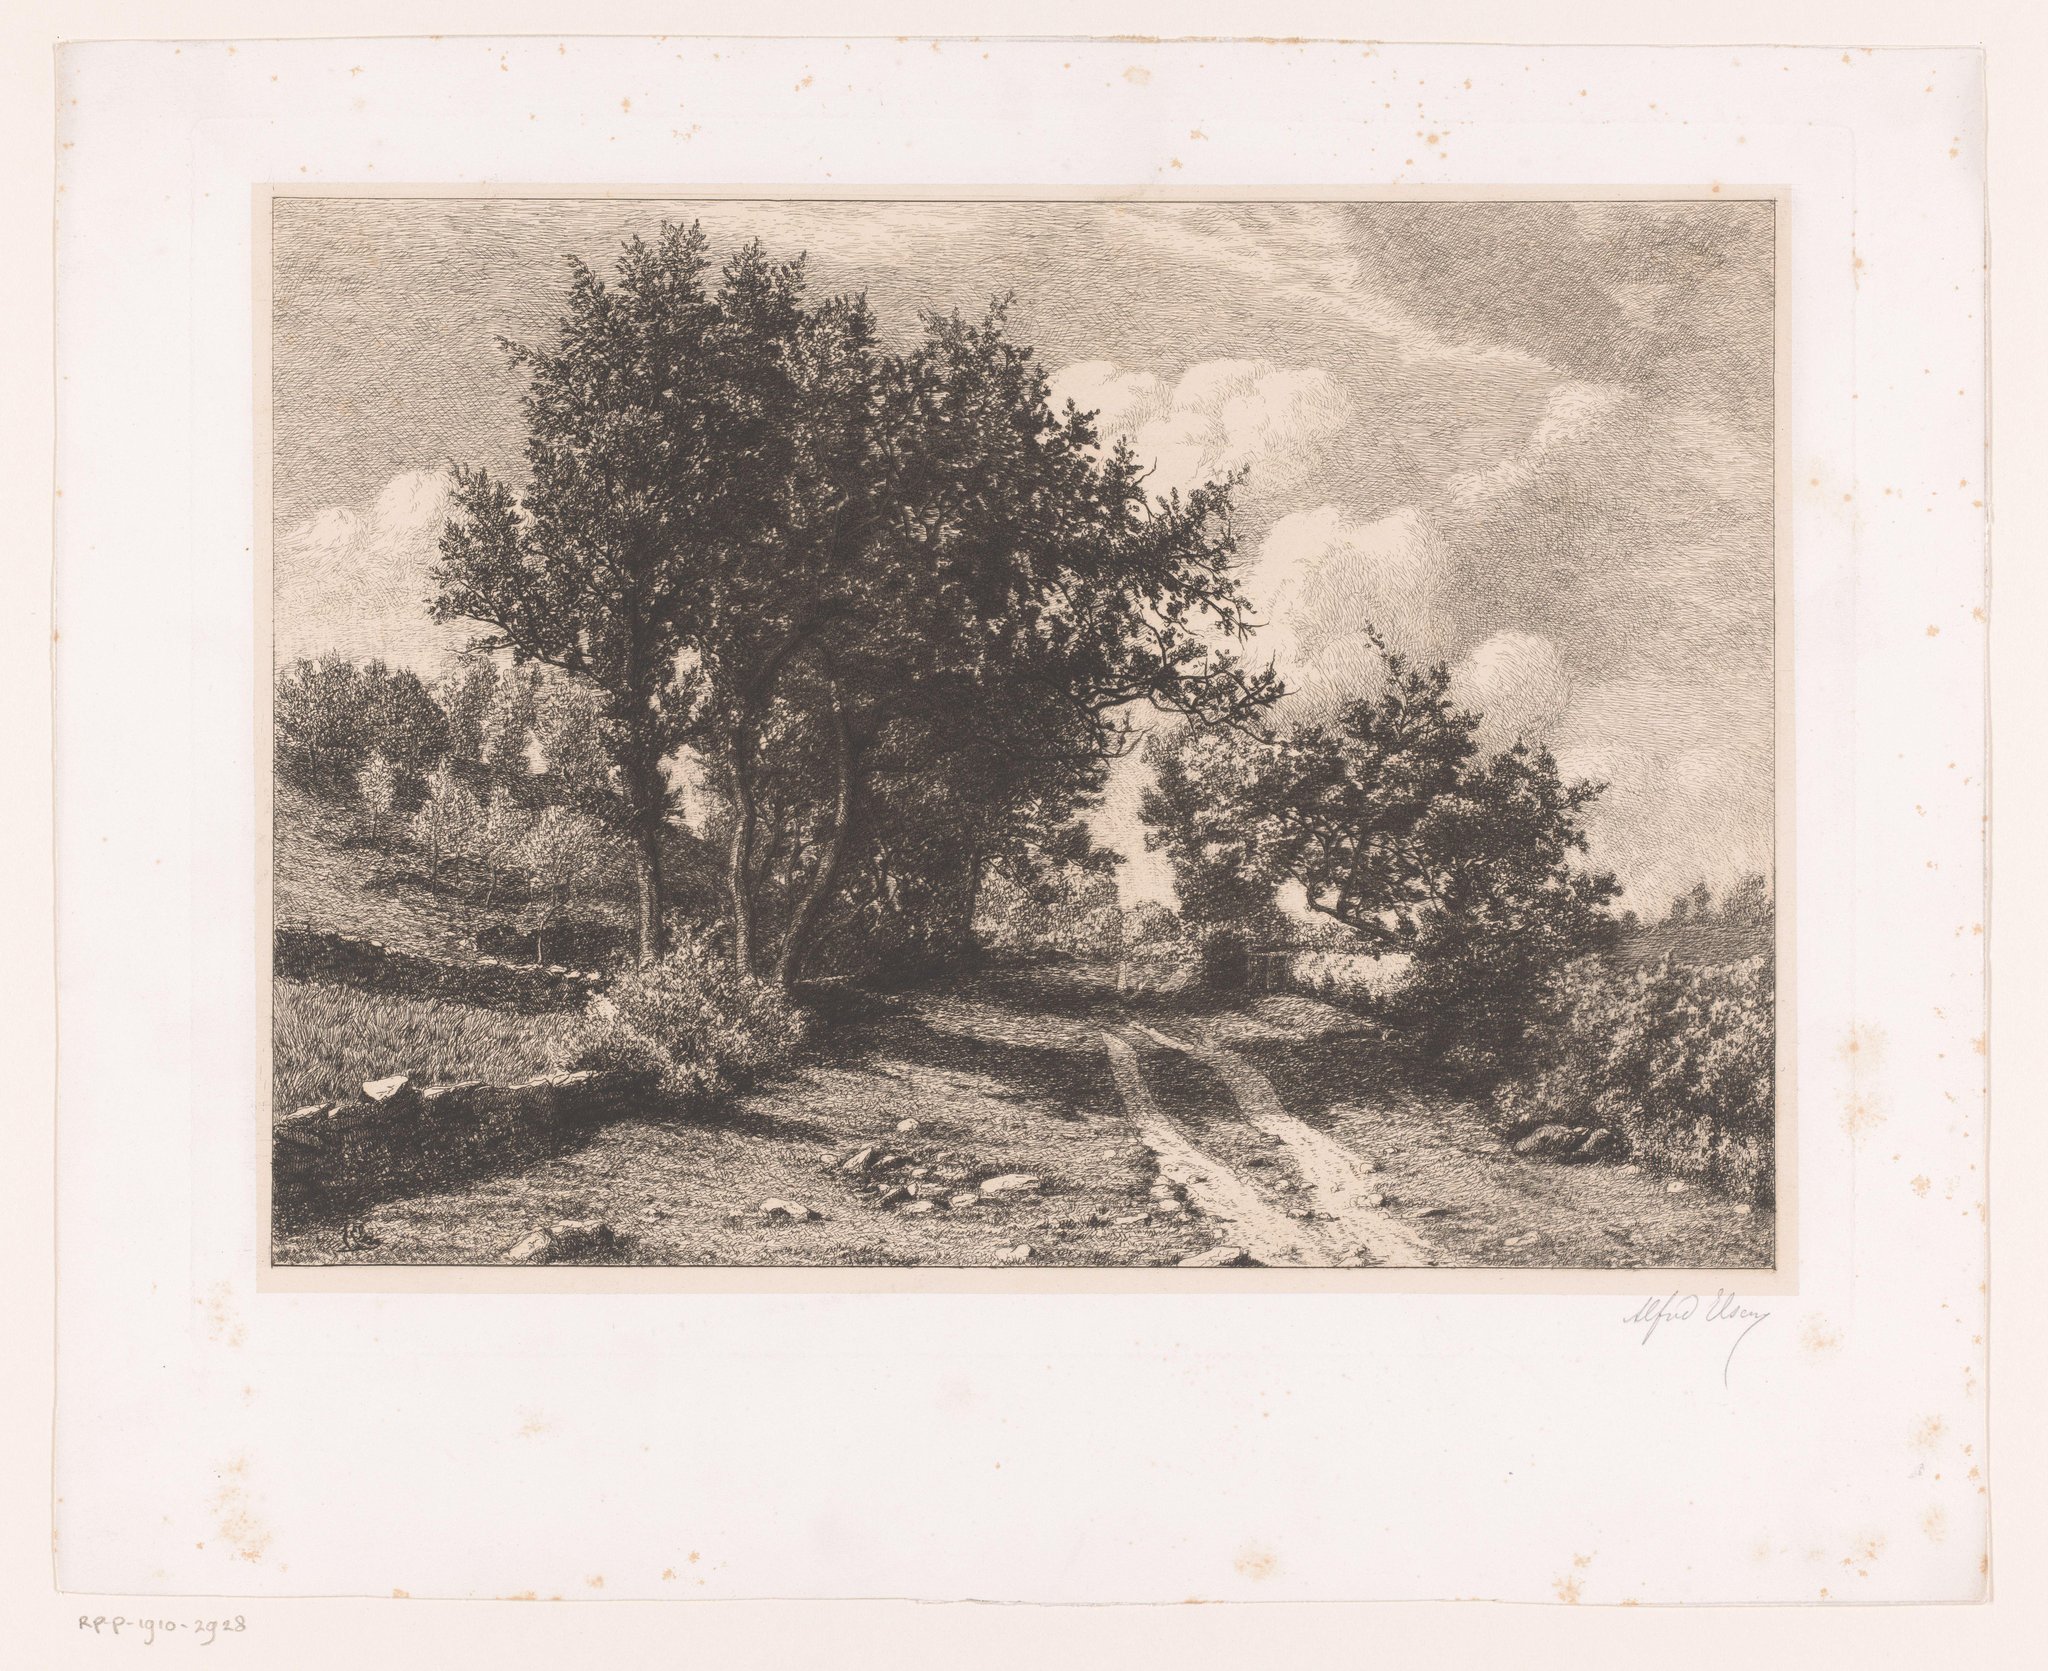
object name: print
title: Landschap met landweg en lage stenen omheiningen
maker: alfred elsen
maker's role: painter, print maker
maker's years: 1850-1914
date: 1860-1910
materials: paper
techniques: etching, intaglio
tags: landscapes, road, path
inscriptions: collector's mark: Lugt 2228